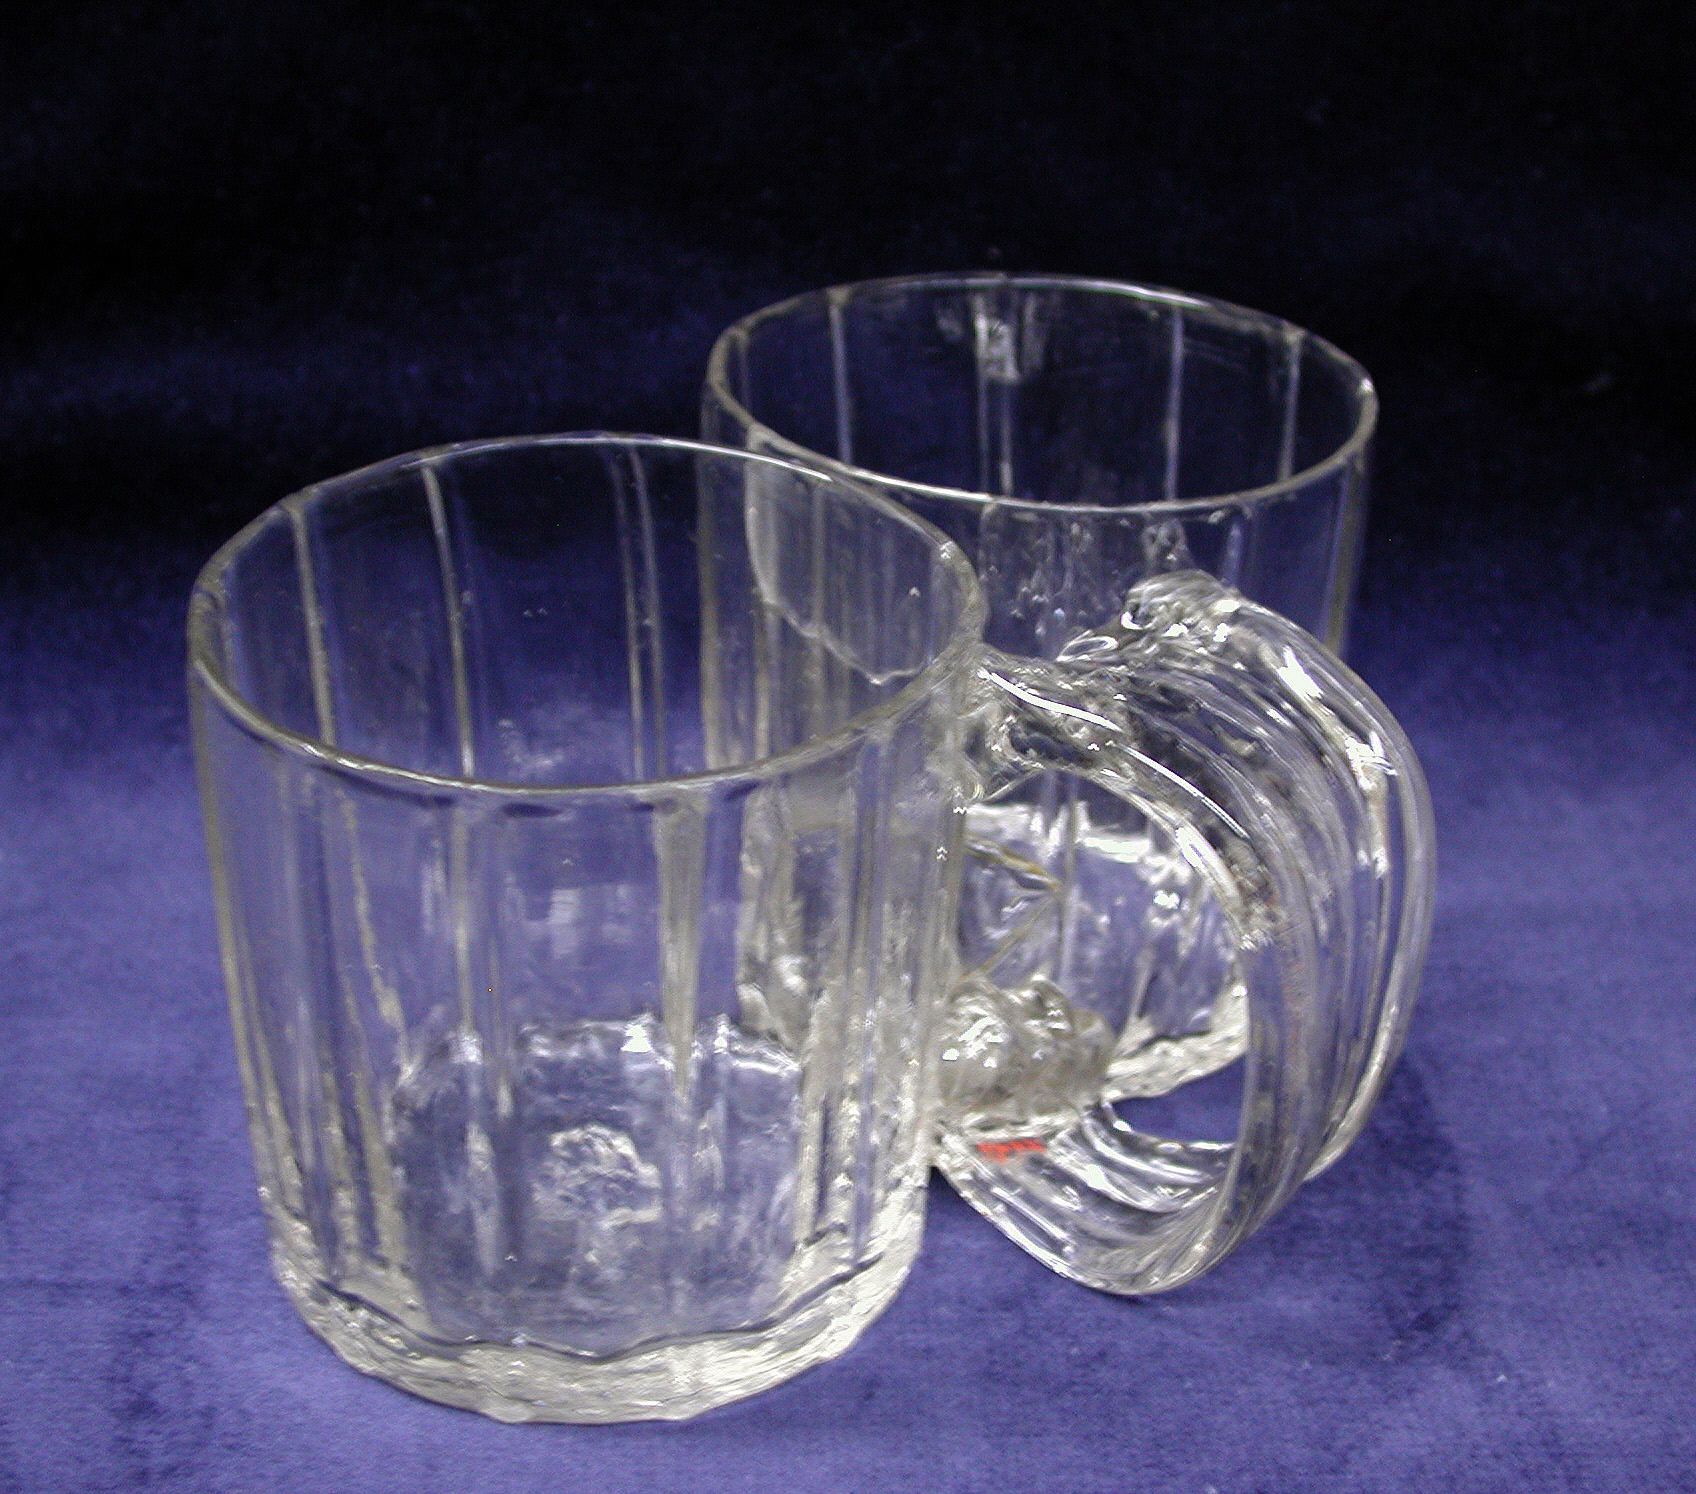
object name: cruet frame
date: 1767-1800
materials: glass